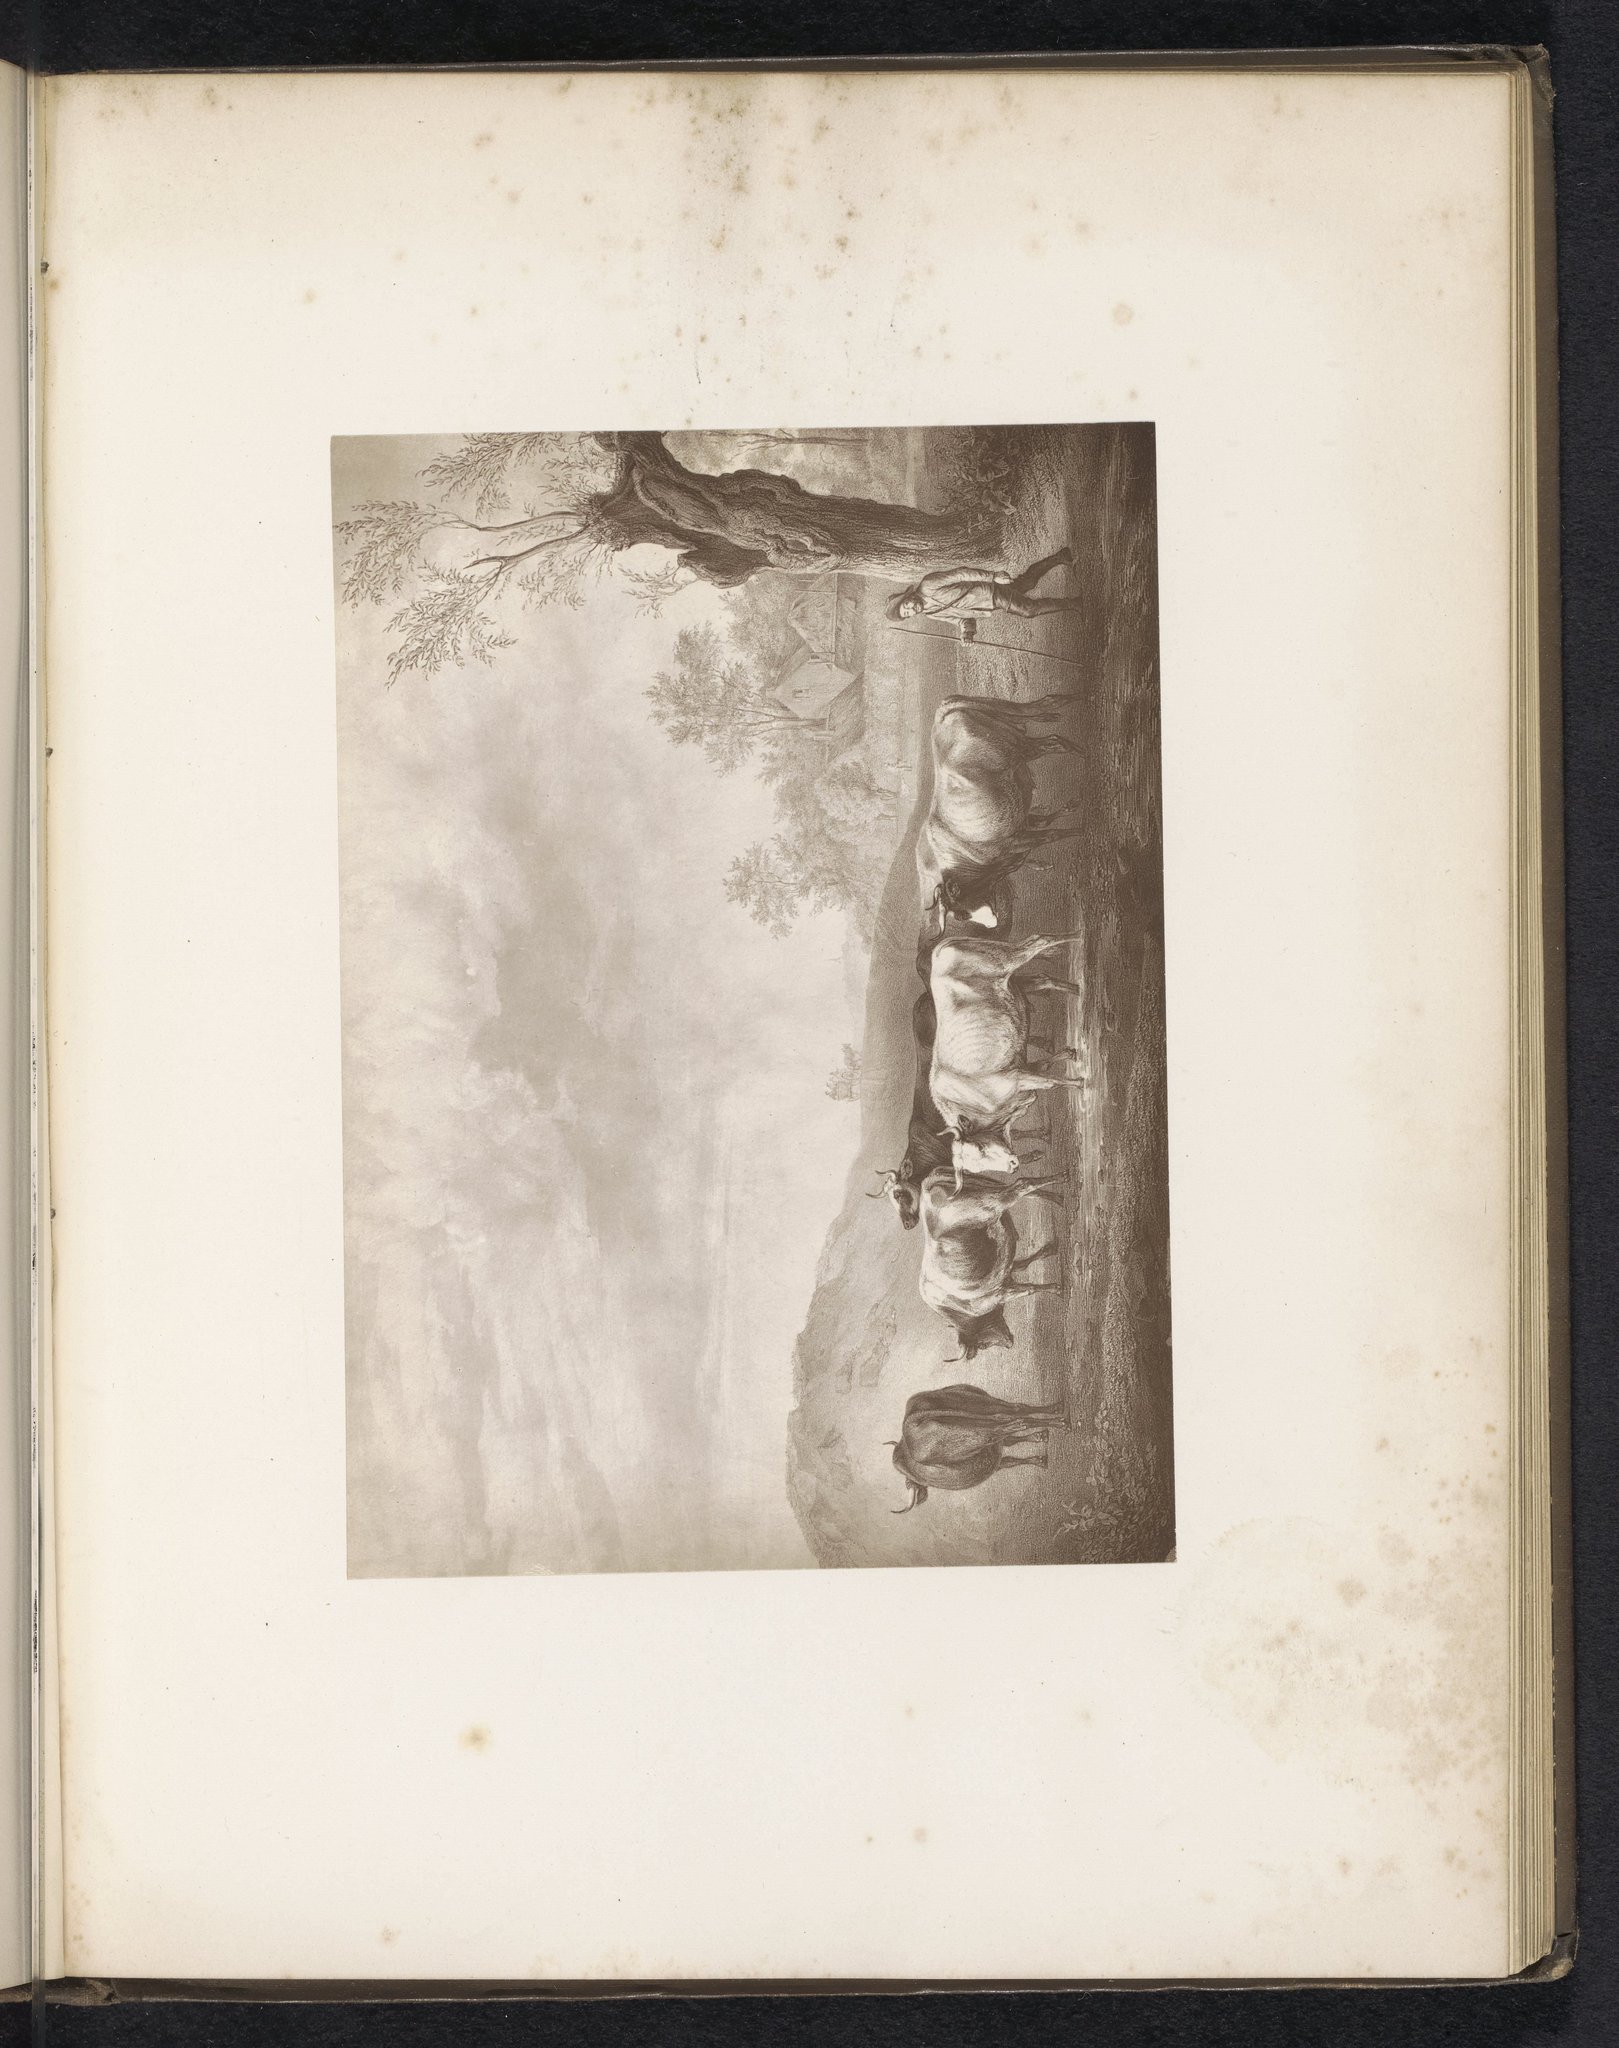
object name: page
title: Fotoreproductie van een prent naar een schilderij, voorstellende herder met een kudde koeien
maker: Anonymous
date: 1859-1869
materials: photographic support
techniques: albumen print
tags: herding, herdsman, herdswoman, shepherd, shepherdess, cowherd, etc., bovine cattle